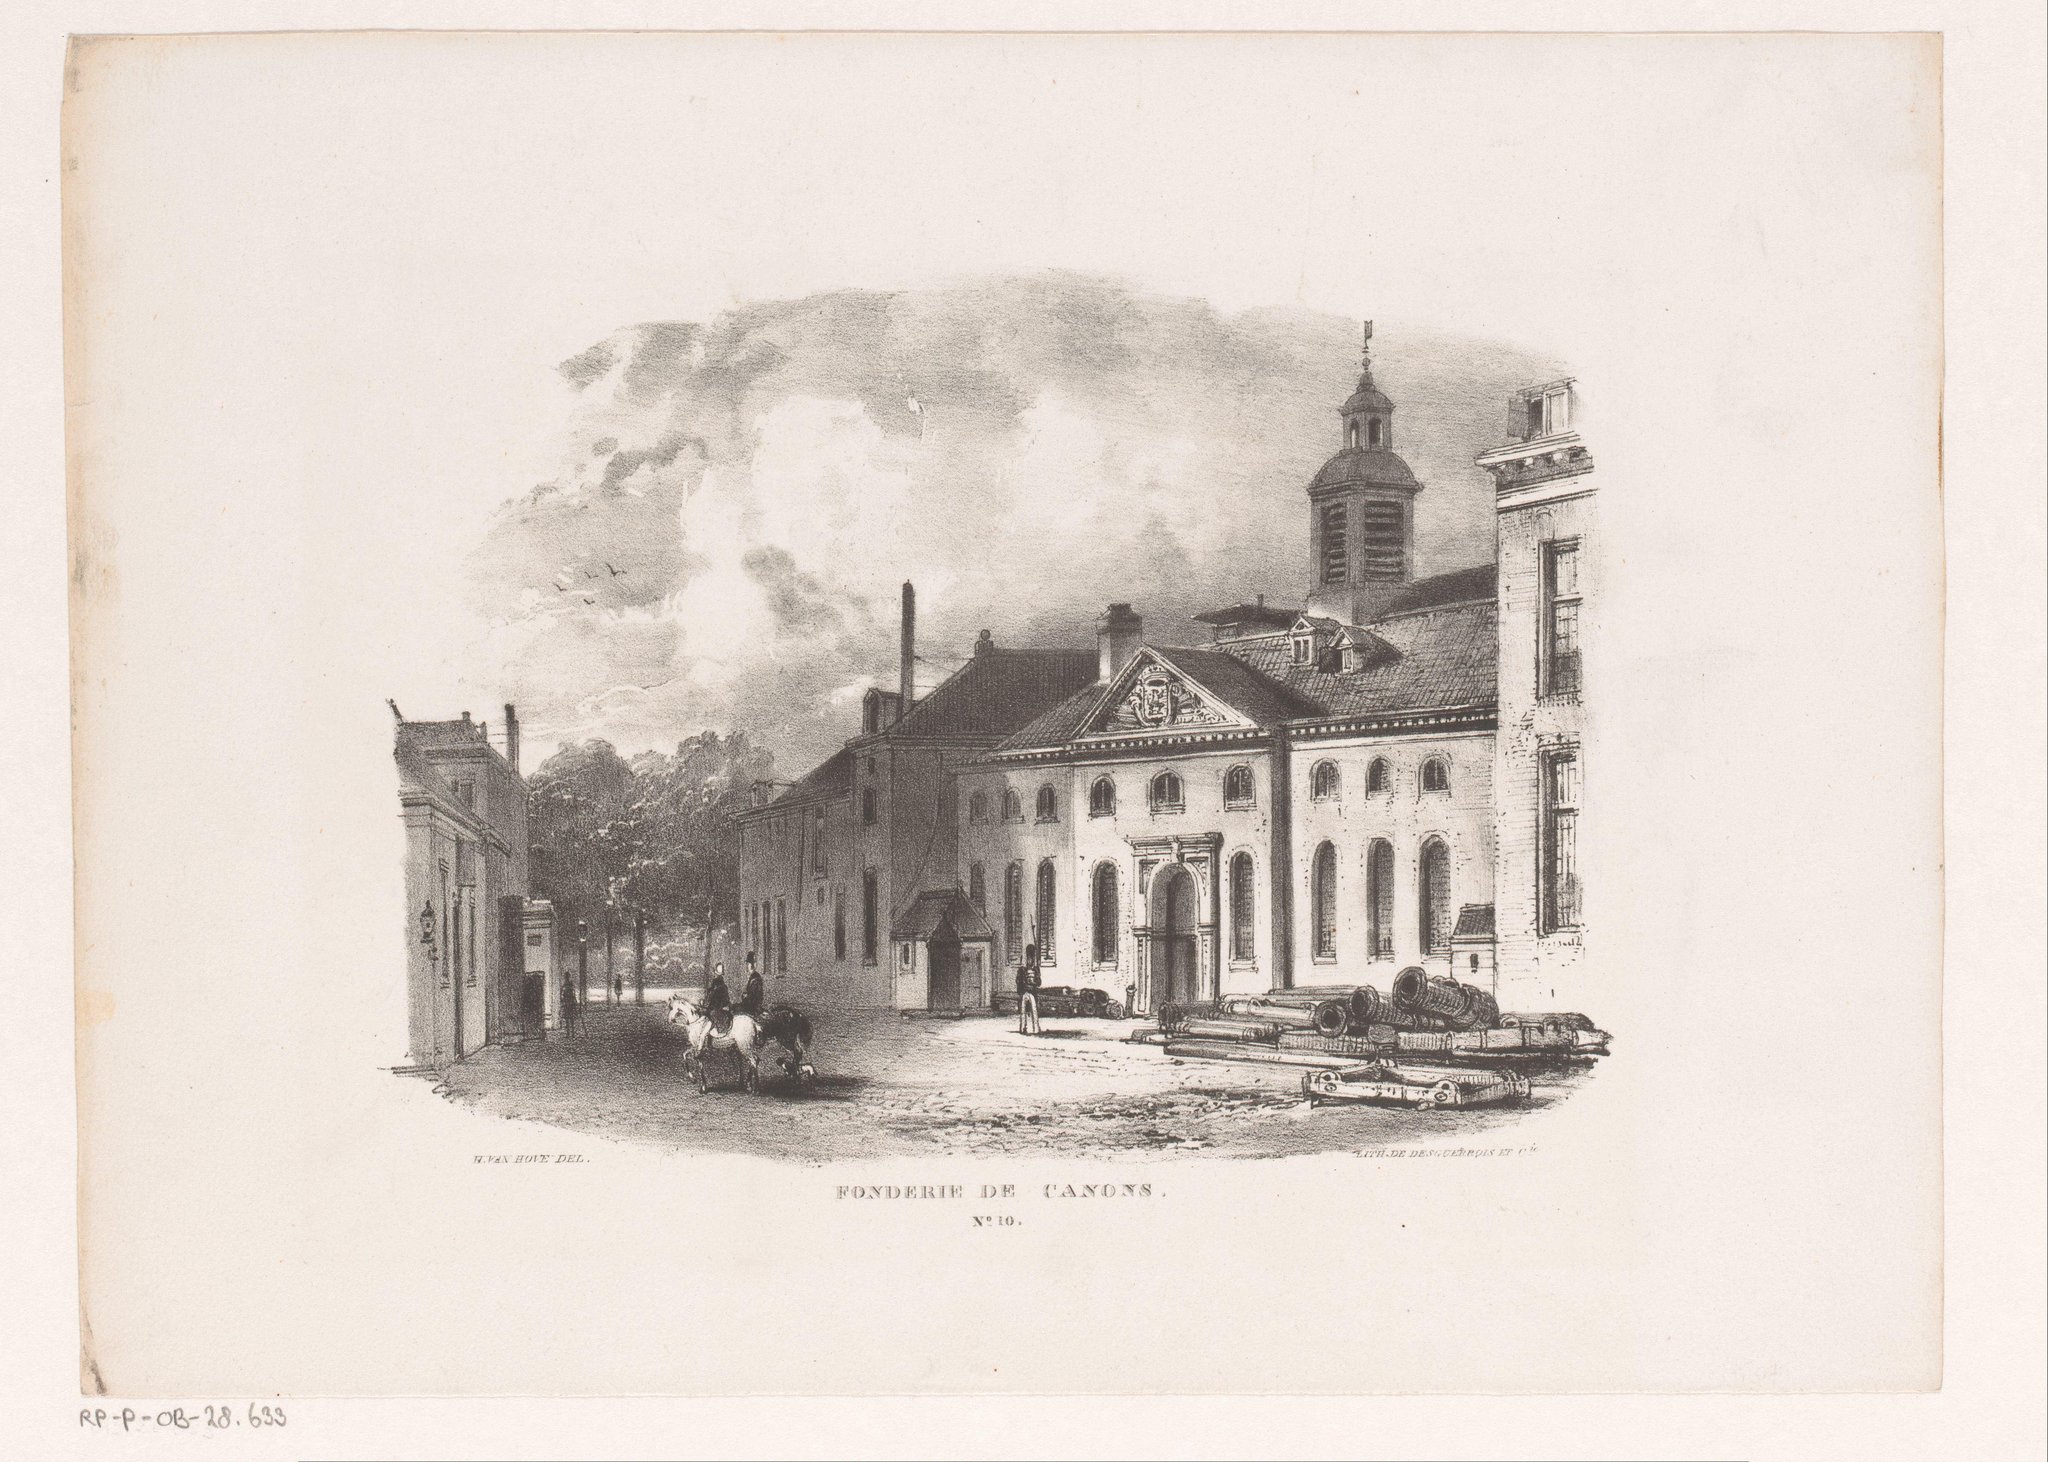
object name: print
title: Fonderie de canon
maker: huib van hove bz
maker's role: painter, print maker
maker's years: 1814-1867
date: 1824-1867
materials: paper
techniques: lithograph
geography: amsterdam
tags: firearms: cannon, the hague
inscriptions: collector's mark: Lugt 2228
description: Voor het gebouw liggen kanonnen. Genummerd midden onder: no. 10.